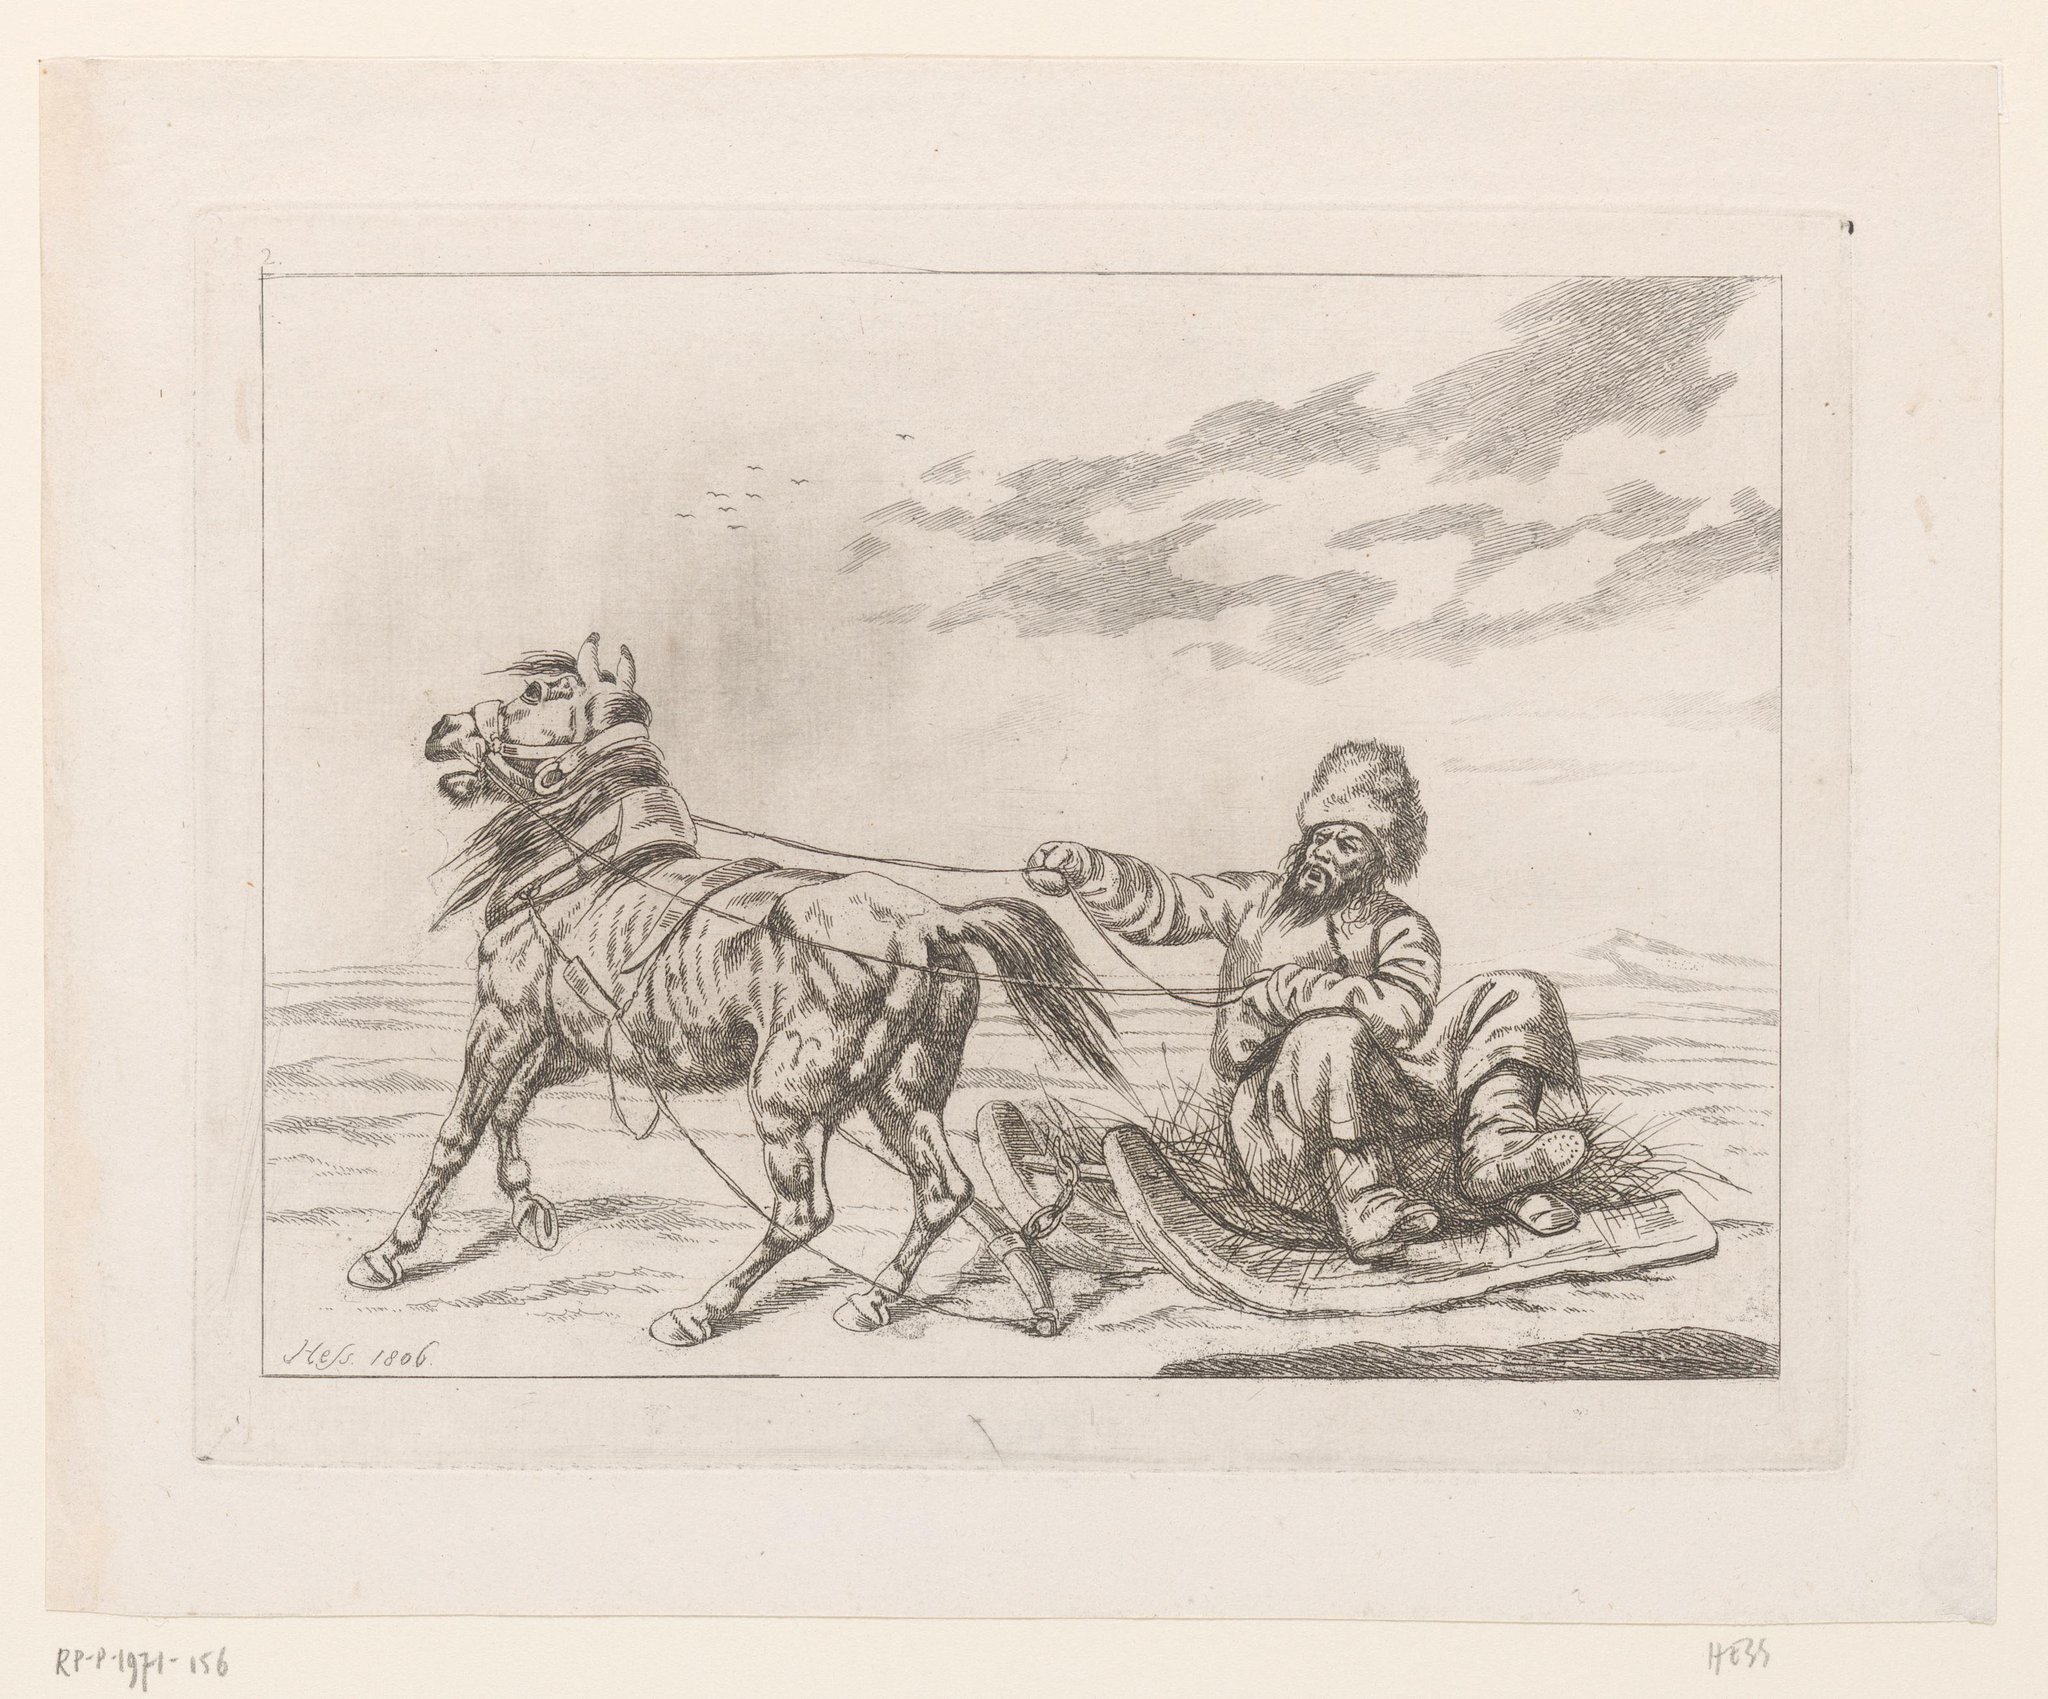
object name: print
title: Kozak op een slee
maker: hess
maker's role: print maker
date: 1806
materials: paper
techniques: etching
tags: sleigh, sledge (non-sport), europeans (with name)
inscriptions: collector's mark: Lugt 2760, collector's mark: Lugt 2228, collector's mark: ‘D A’